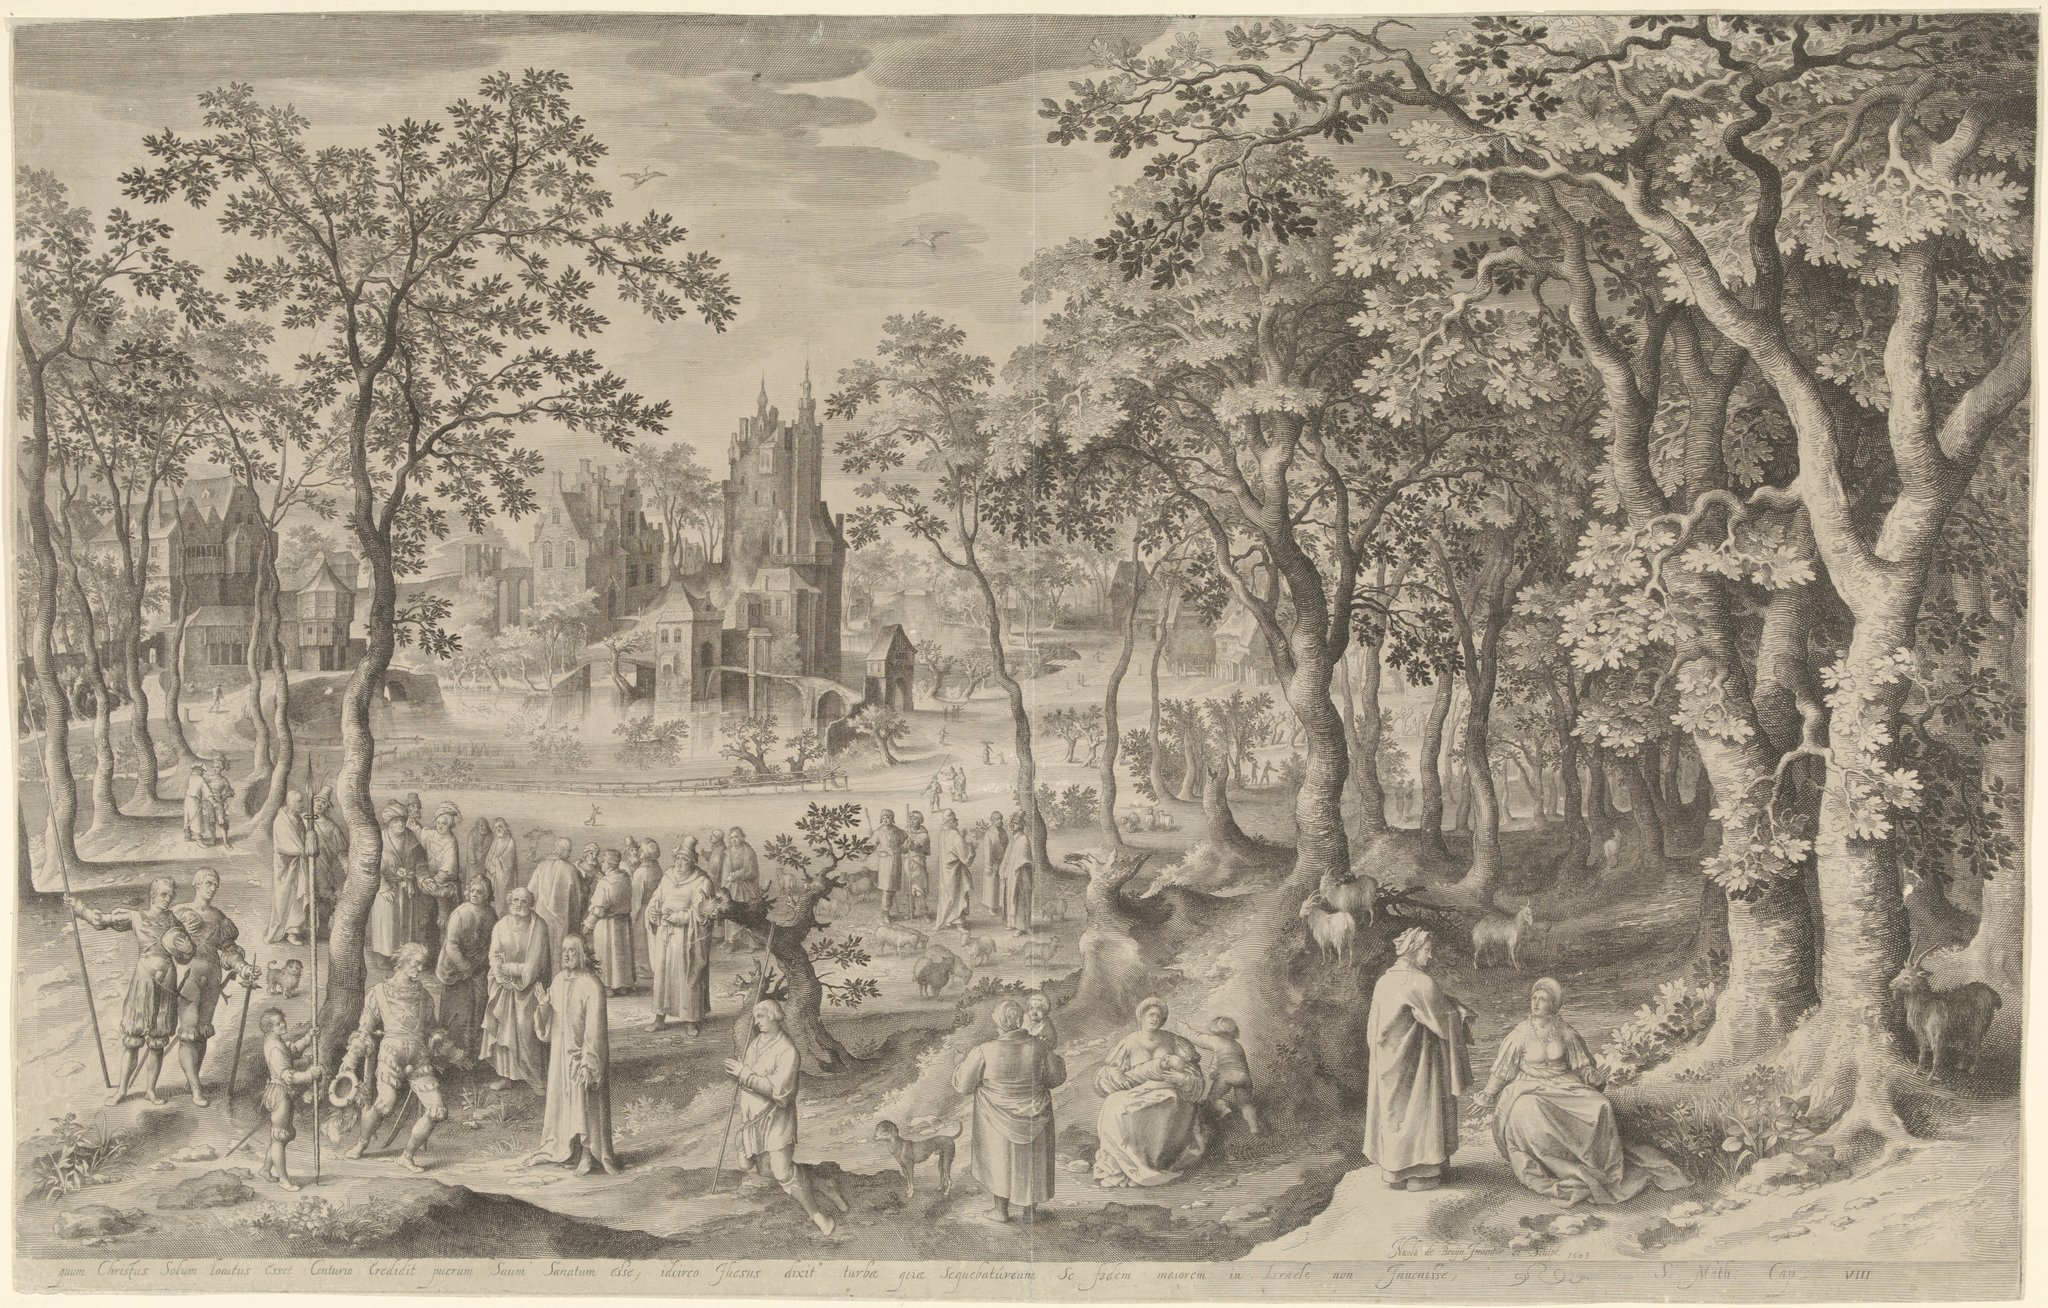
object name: print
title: Genezing van de slaaf van de Hoofdman van Kafarnaüm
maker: nicolaes de bruyn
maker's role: print maker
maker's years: 1571-1656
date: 1603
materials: paper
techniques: engraving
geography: antwerp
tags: the centurion of capernaum, kneeling before christ, begs him to heal his paralytic servant (or son) (matthew 8:5-13; luke 7:1-10; john 4:46-54), landscape with tower or castle (+ city(-scape) with figures, staffage)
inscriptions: caption: ‘P. Bl. 58’, collector's mark: Lugt 2228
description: Links knielt de hoofdman van Kafarnaüm voor Christus. Hij smeekt om de genezing van zijn knecht. Rondom Christus zijn leerlingen. Op de achtergrond een kasteel. De prent heeft een Latijns onderschrift.